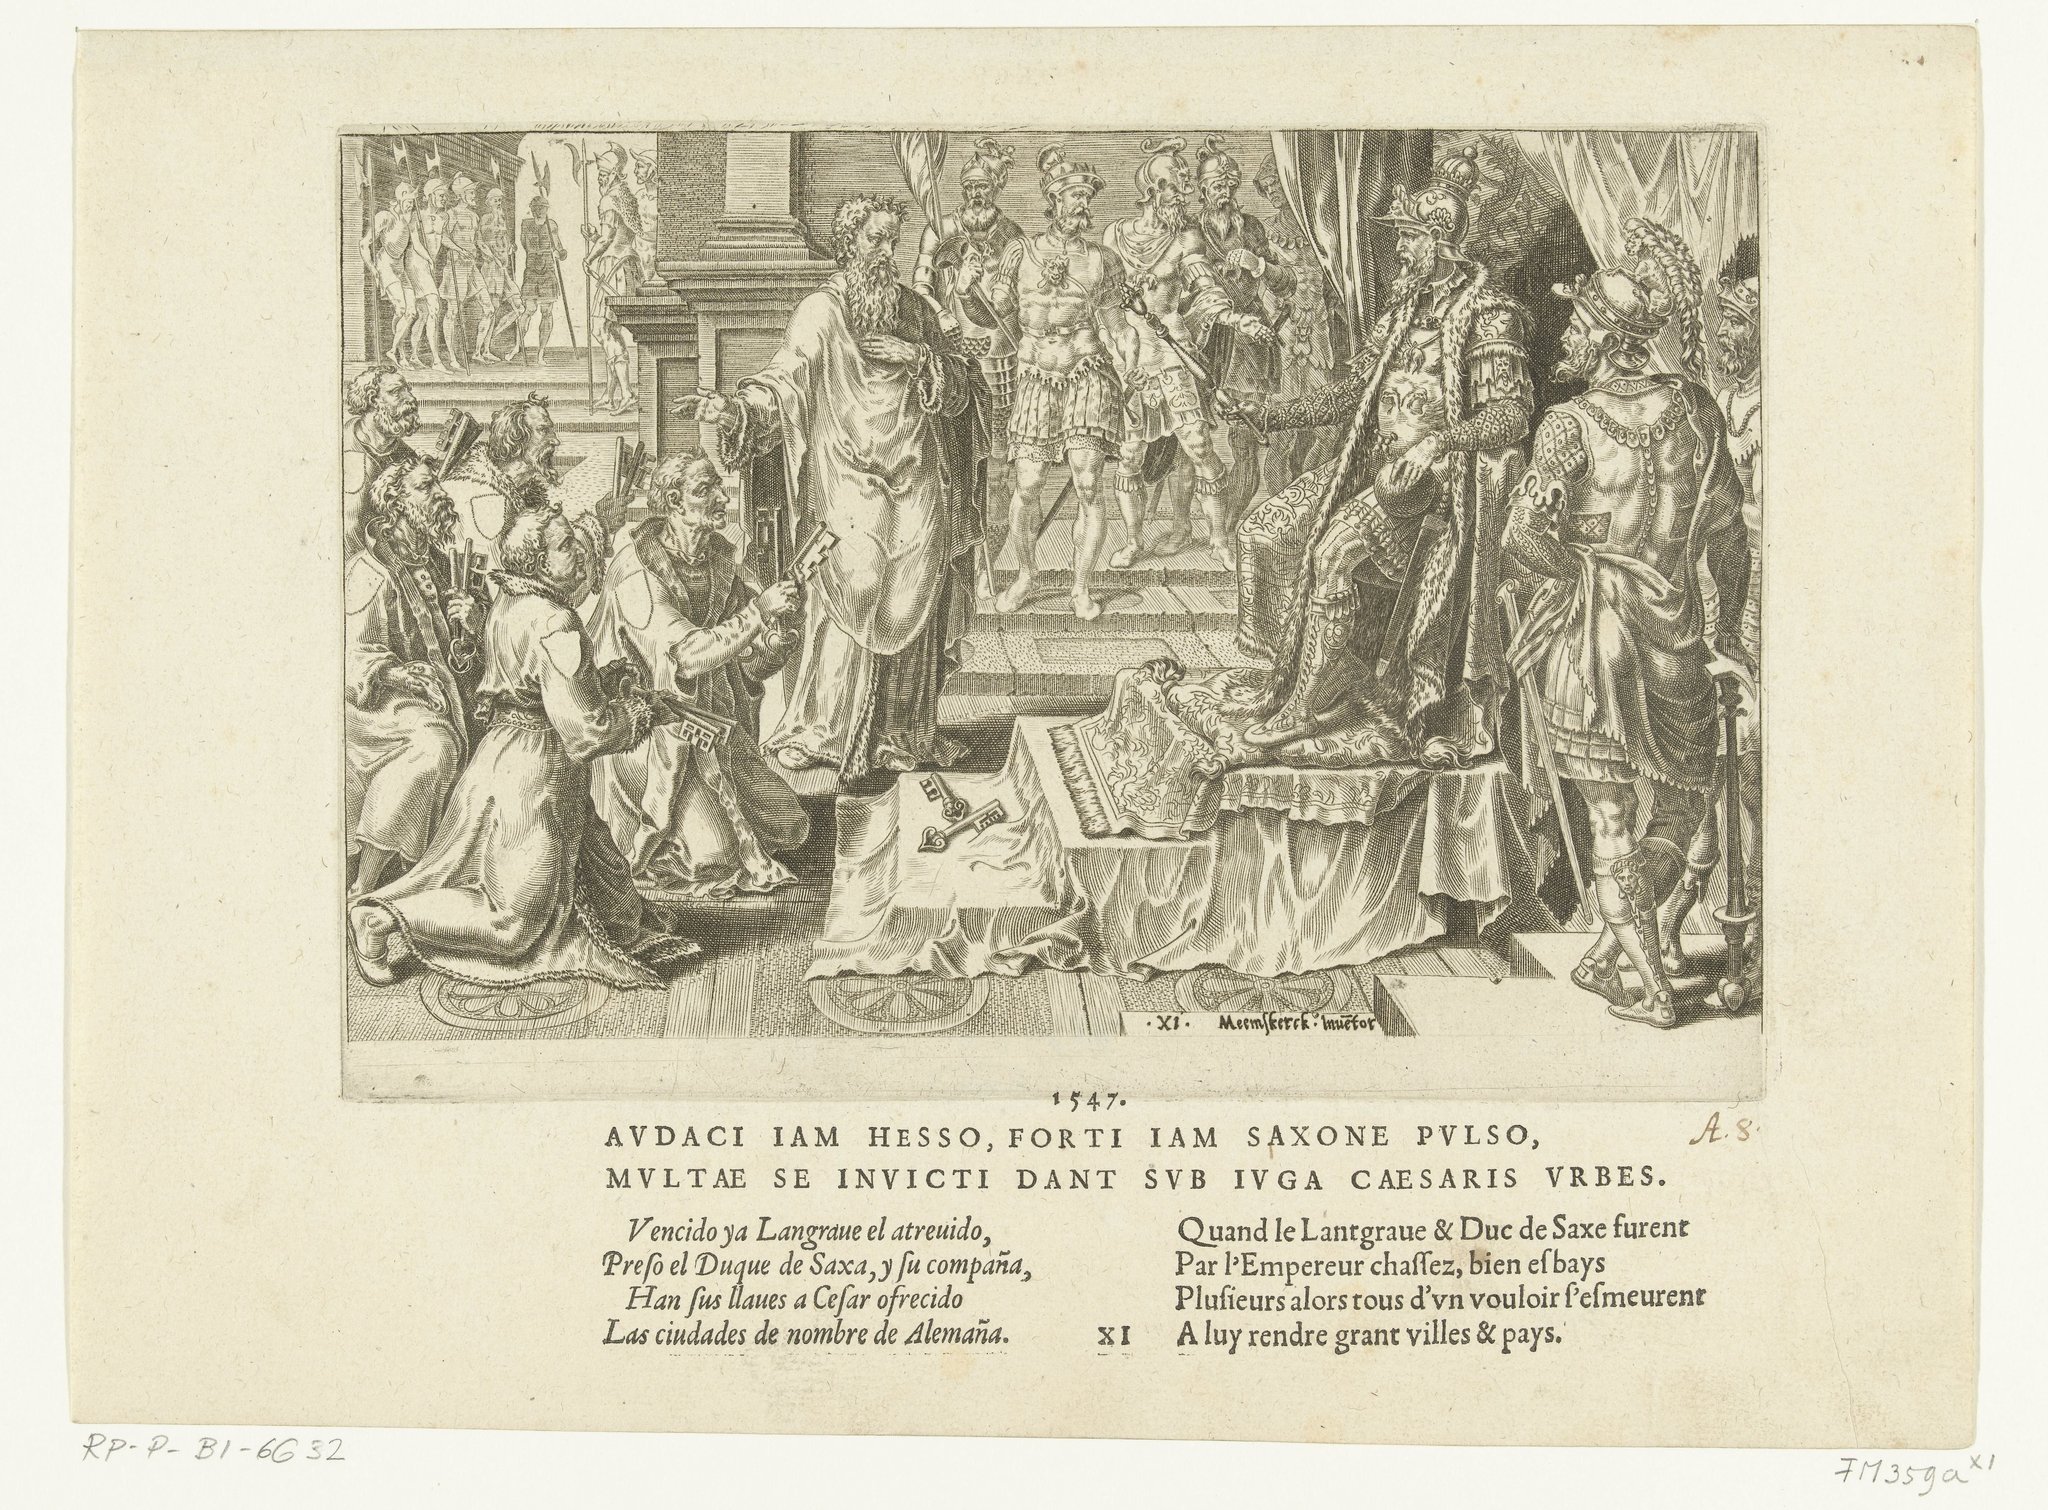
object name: history print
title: Triomfen van Karel V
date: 1555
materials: paper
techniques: engraving, etching, letterpress printing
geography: antwerp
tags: ghent, charles v (holy roman emperor and king of spain), surrender of keys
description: De onderwerping van de Duitse steden van het Schmalkaldisch Verbond, 1547. Vertegenwoordigers van de overwonnen steden leggen geknield de sleutels aan de voeten van de keizer. Onderschriften in twee regels Latijn, vier regels Spaans en vier regels Frans.